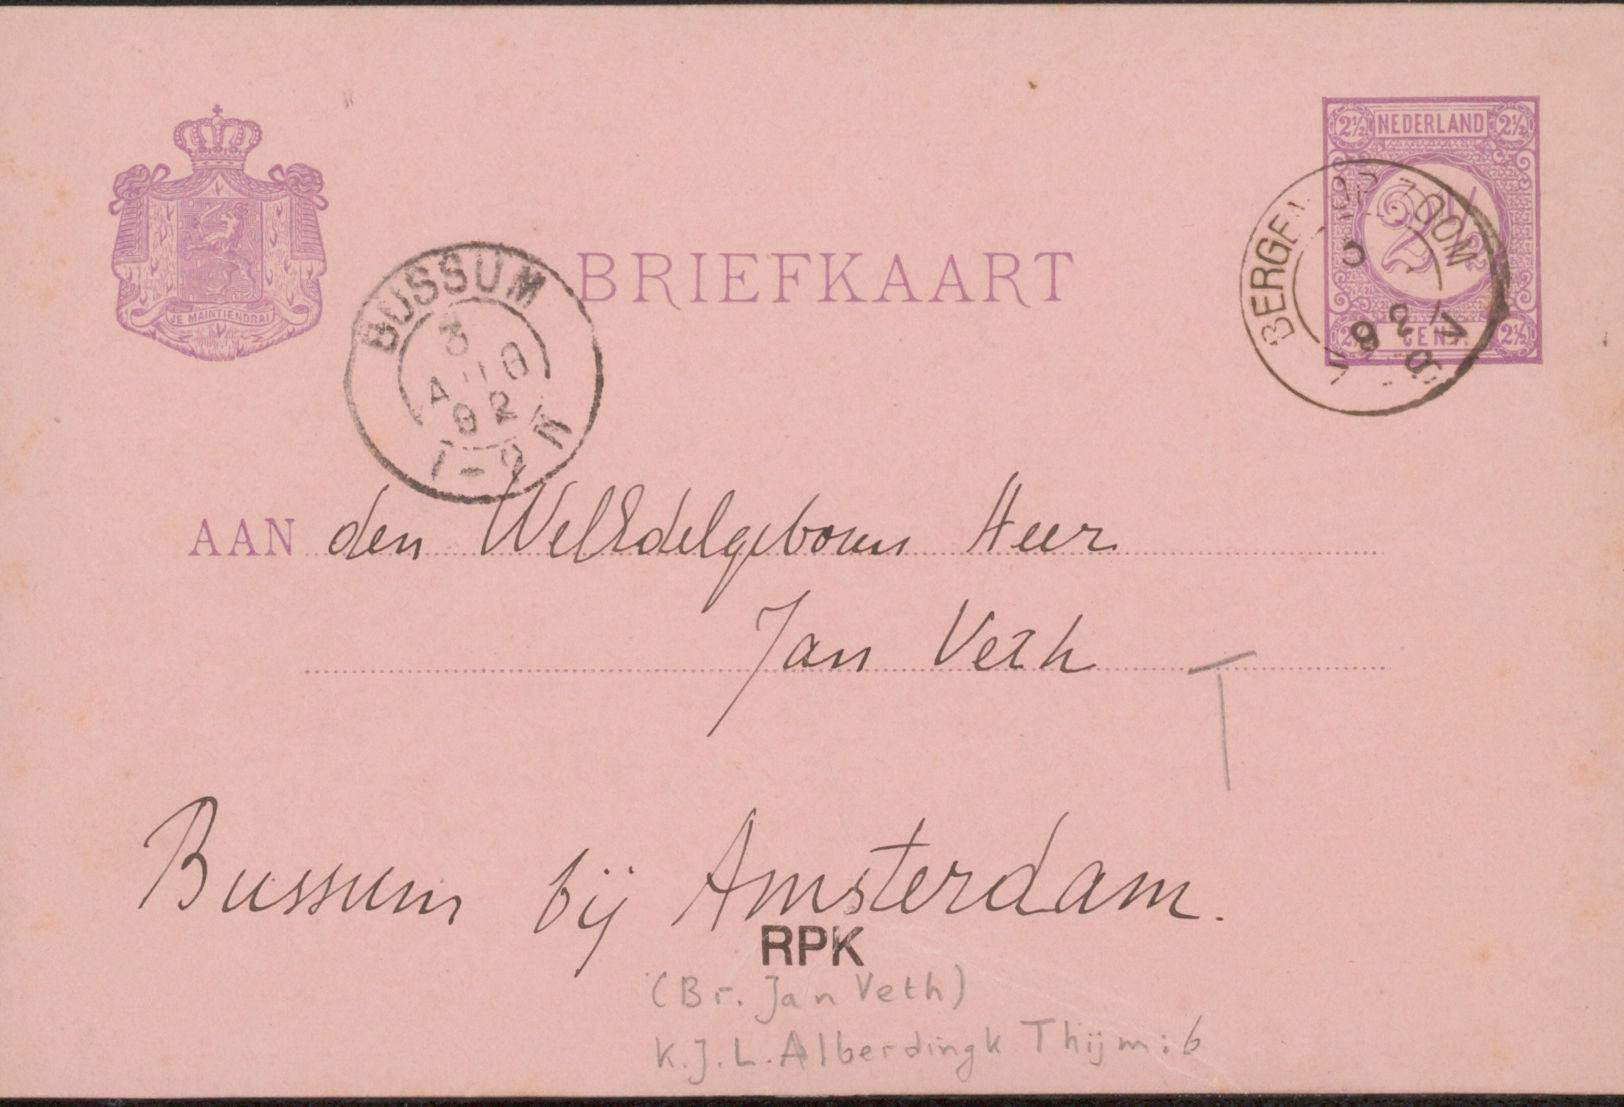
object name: postcard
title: Briefkaart aan Jan Veth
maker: karel johan lodewijk alberdingk thijm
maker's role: criticus, prozaschrijver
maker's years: 1864-1952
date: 1892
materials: cardboard, ink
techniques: pen, writing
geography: bergen op zoom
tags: print maker, jan veth, amsterdam, painter, draughtsman, publisher, josephus albertus alberdingk thijm, historical persons (portraits and scenes from the life)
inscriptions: collector's mark: ‘RPK’